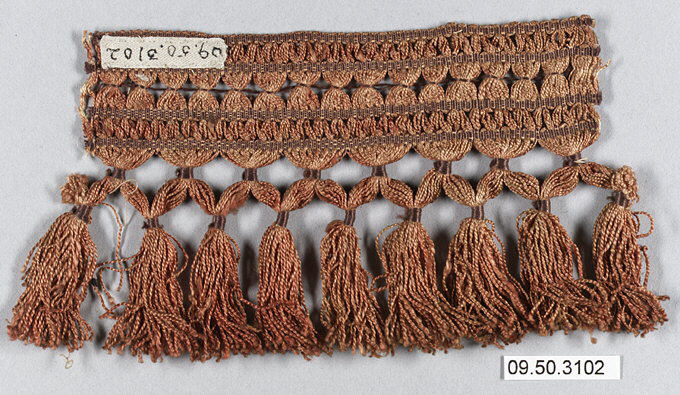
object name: fringe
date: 1801-1900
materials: silk